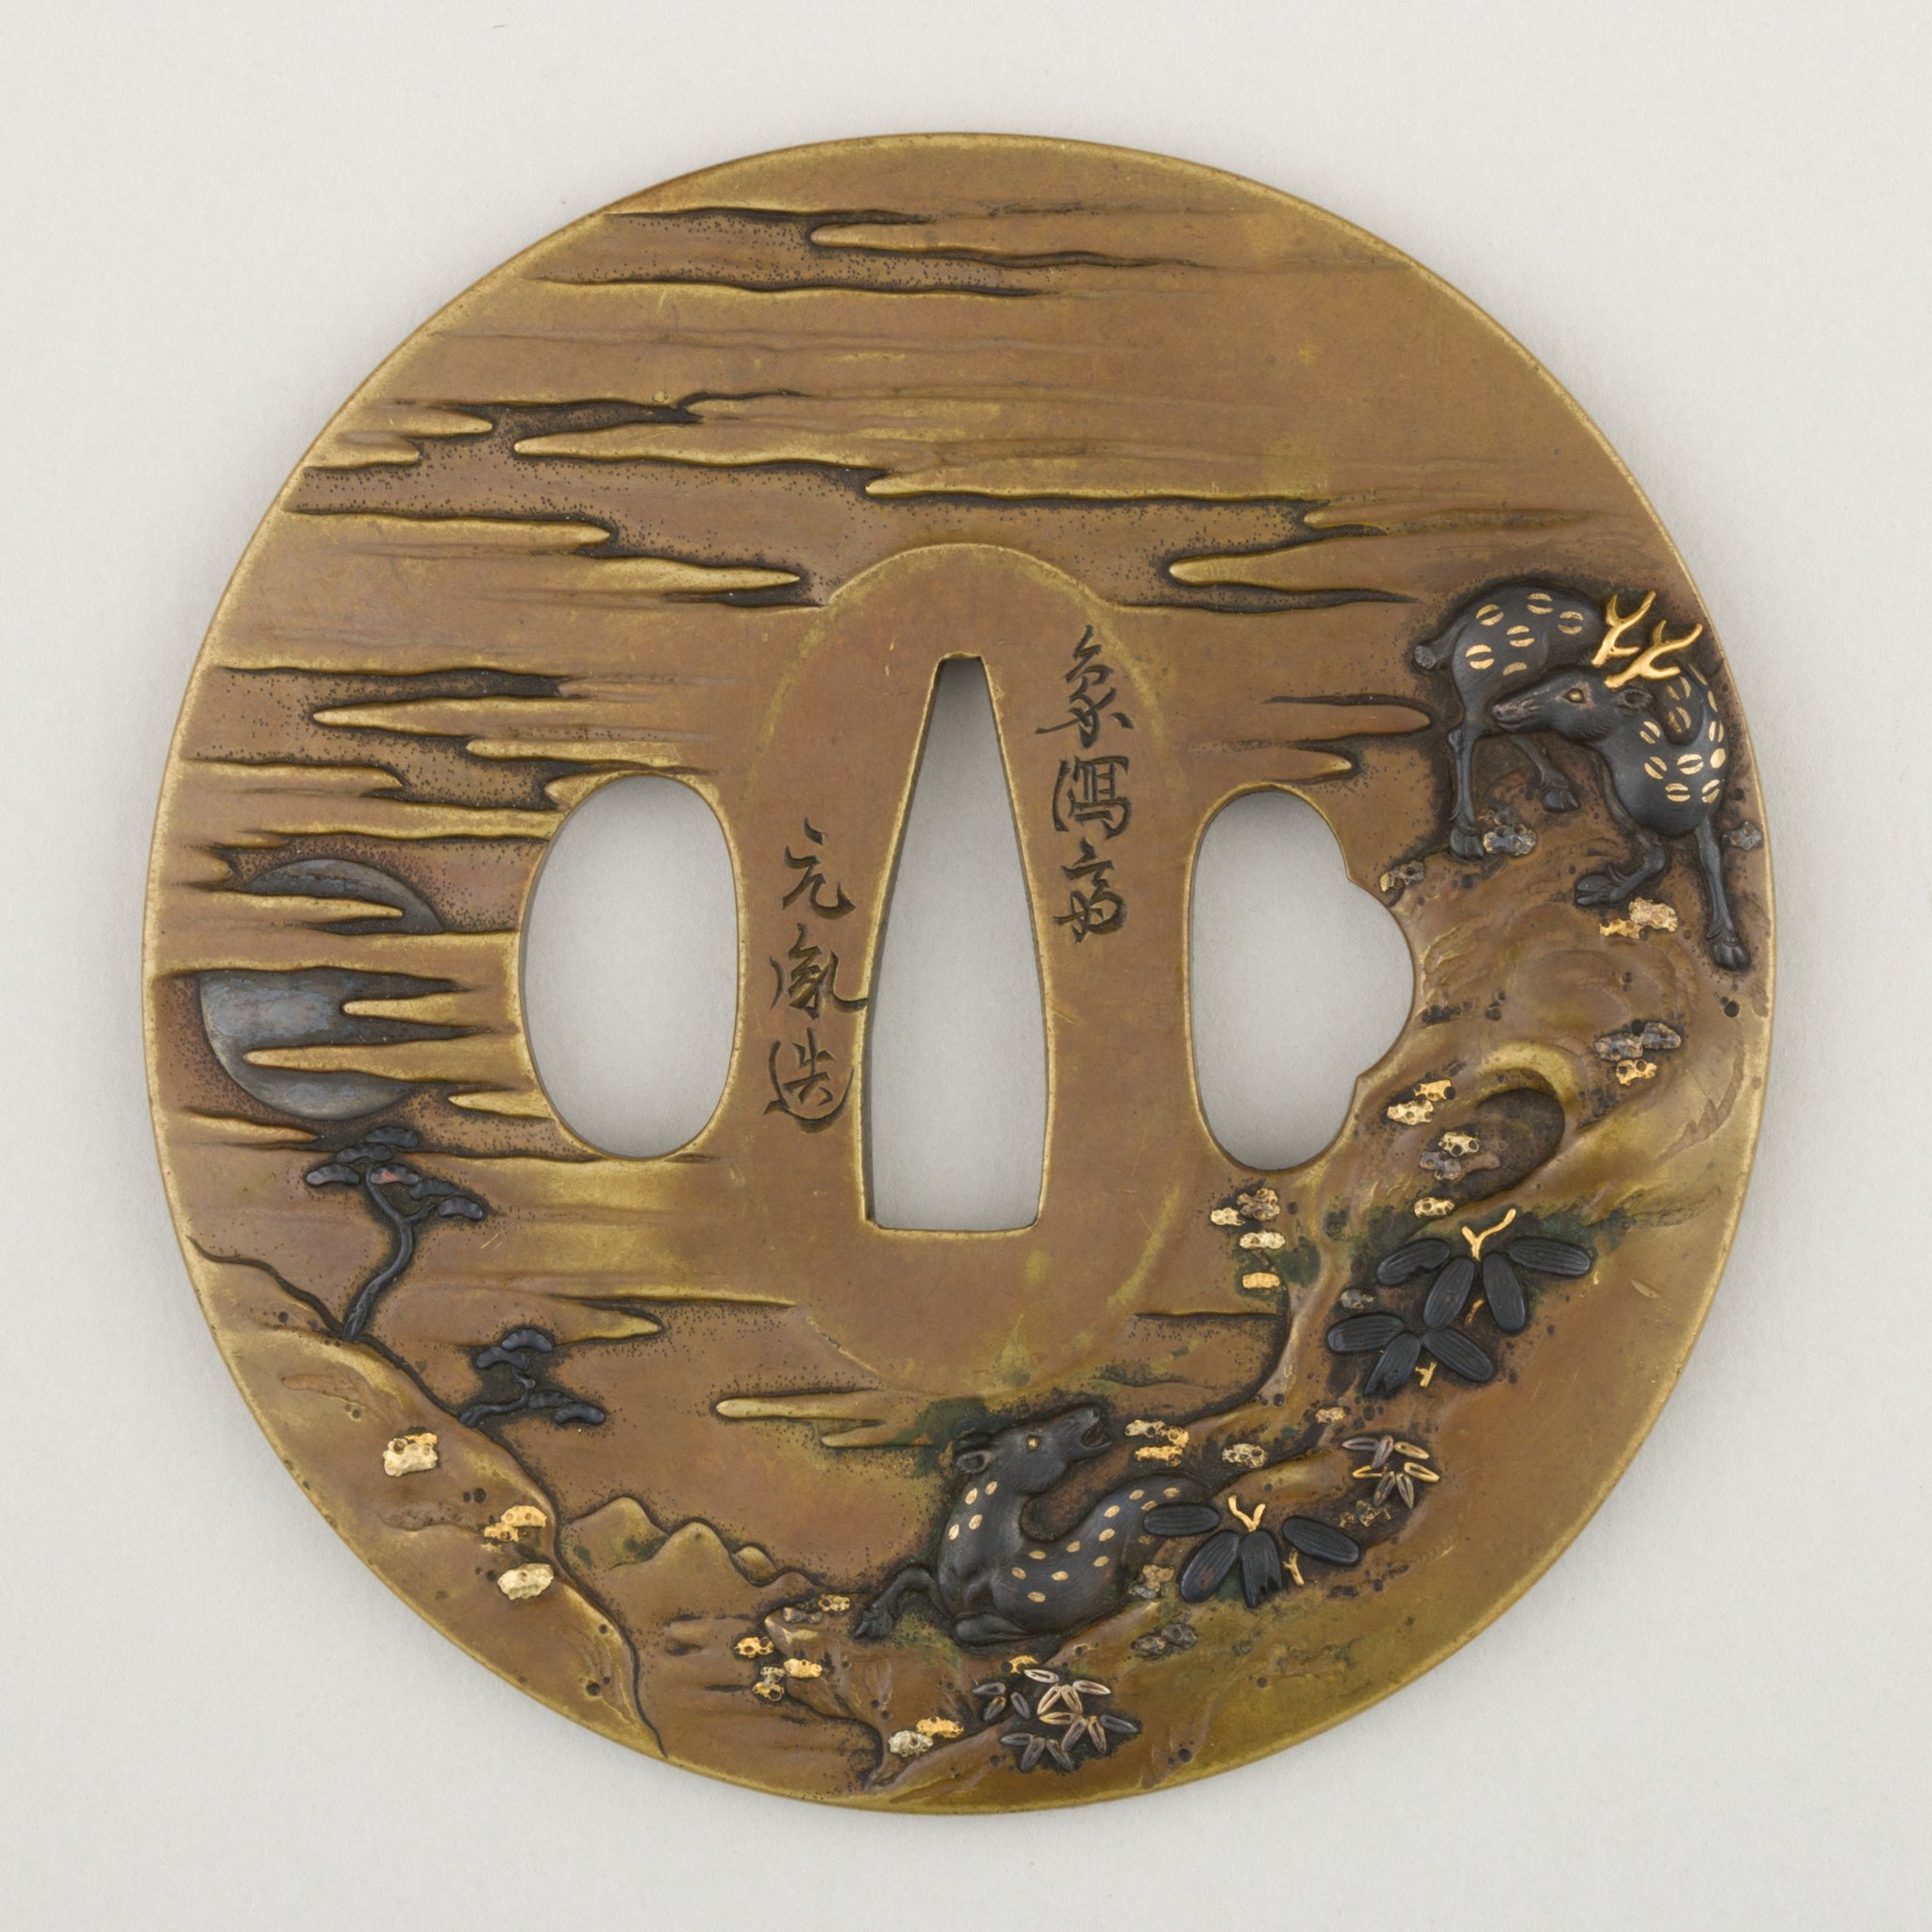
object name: sword guard tsuba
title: Sword Guard (Tsuba)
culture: japanese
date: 1801-1833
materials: copper, copper alloy, gold alloy, gold, silver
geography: japan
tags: deer